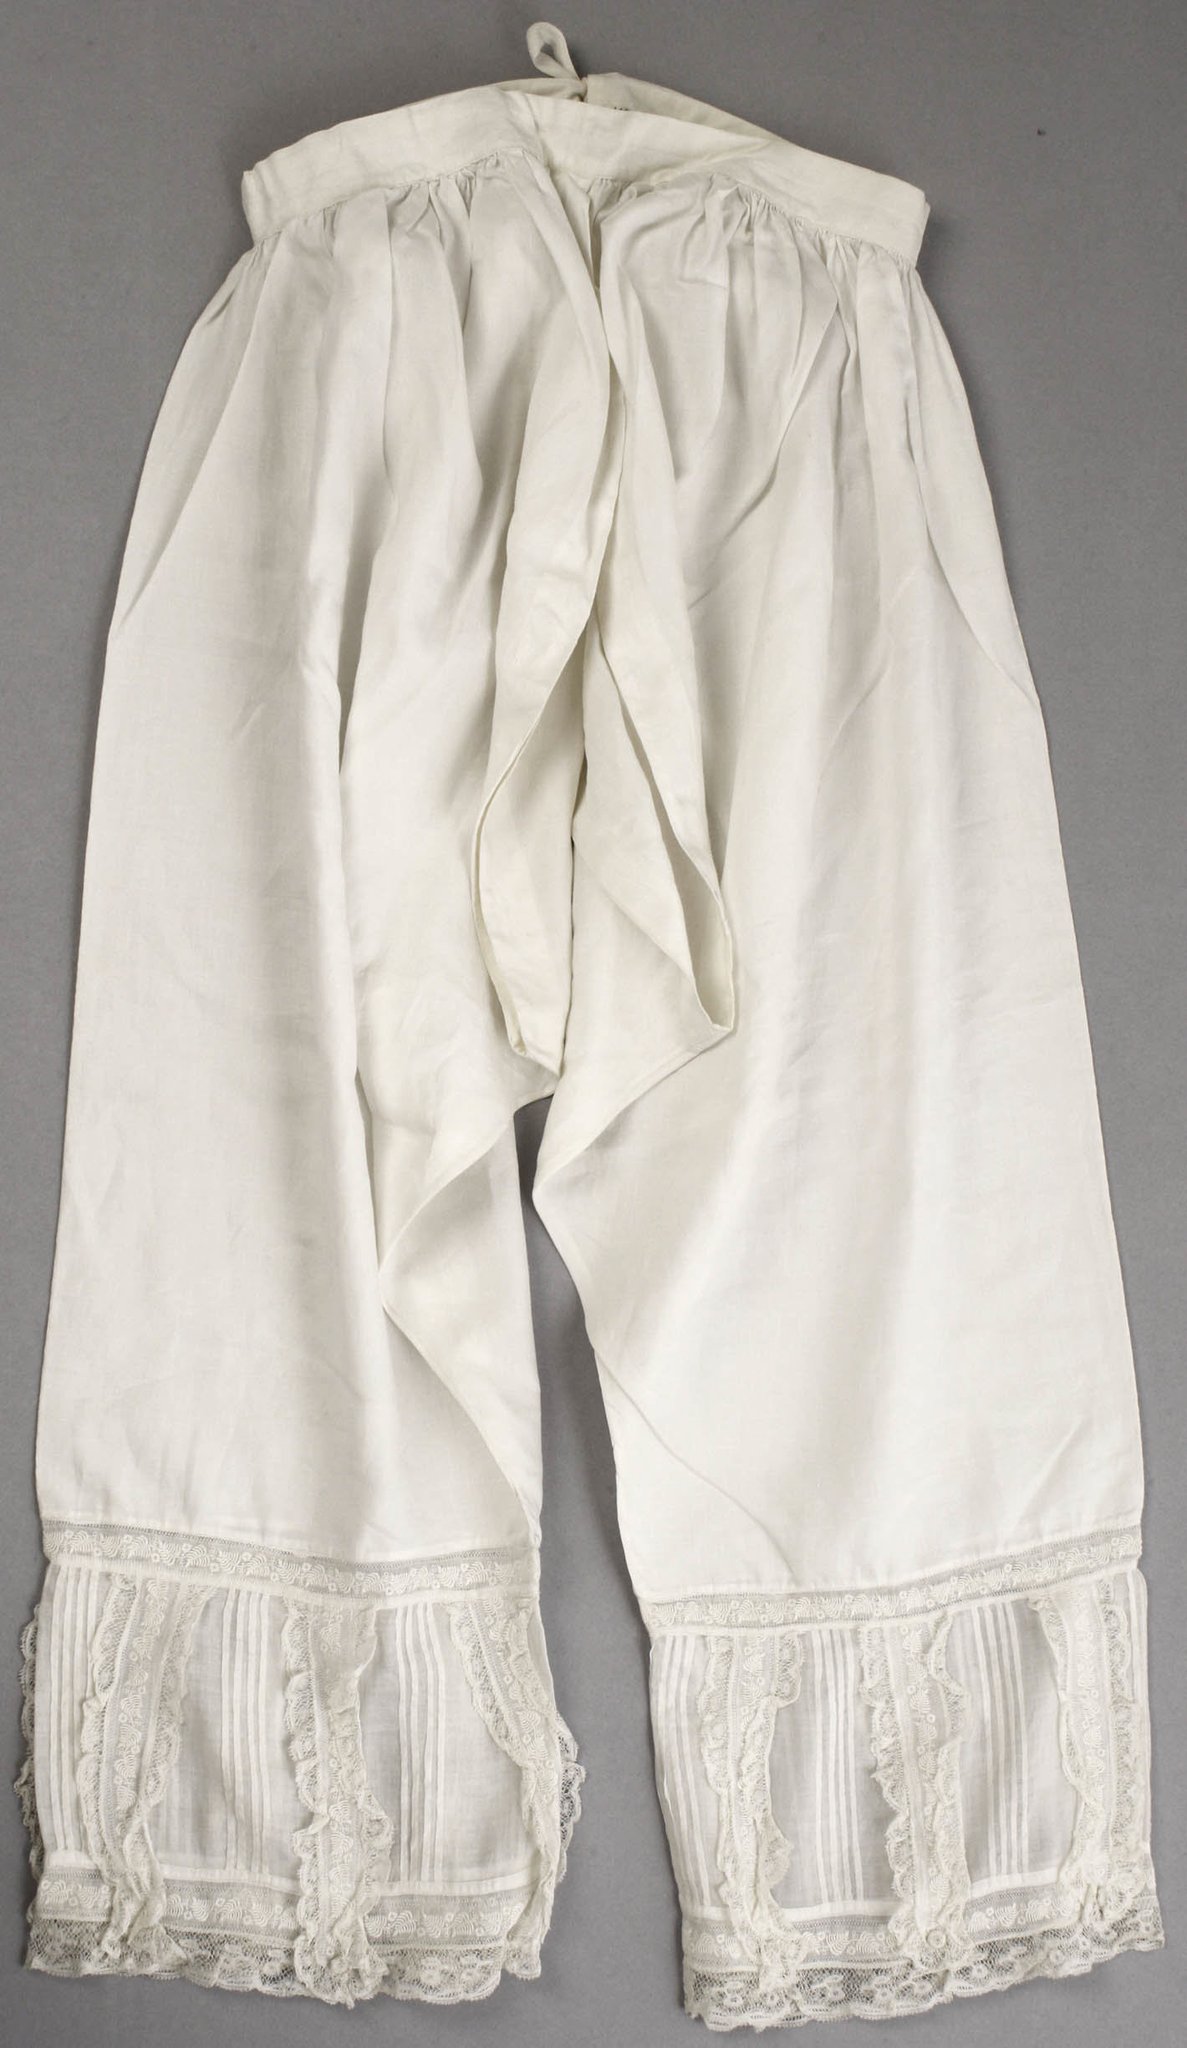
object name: drawer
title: Drawers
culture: american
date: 1874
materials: cotton